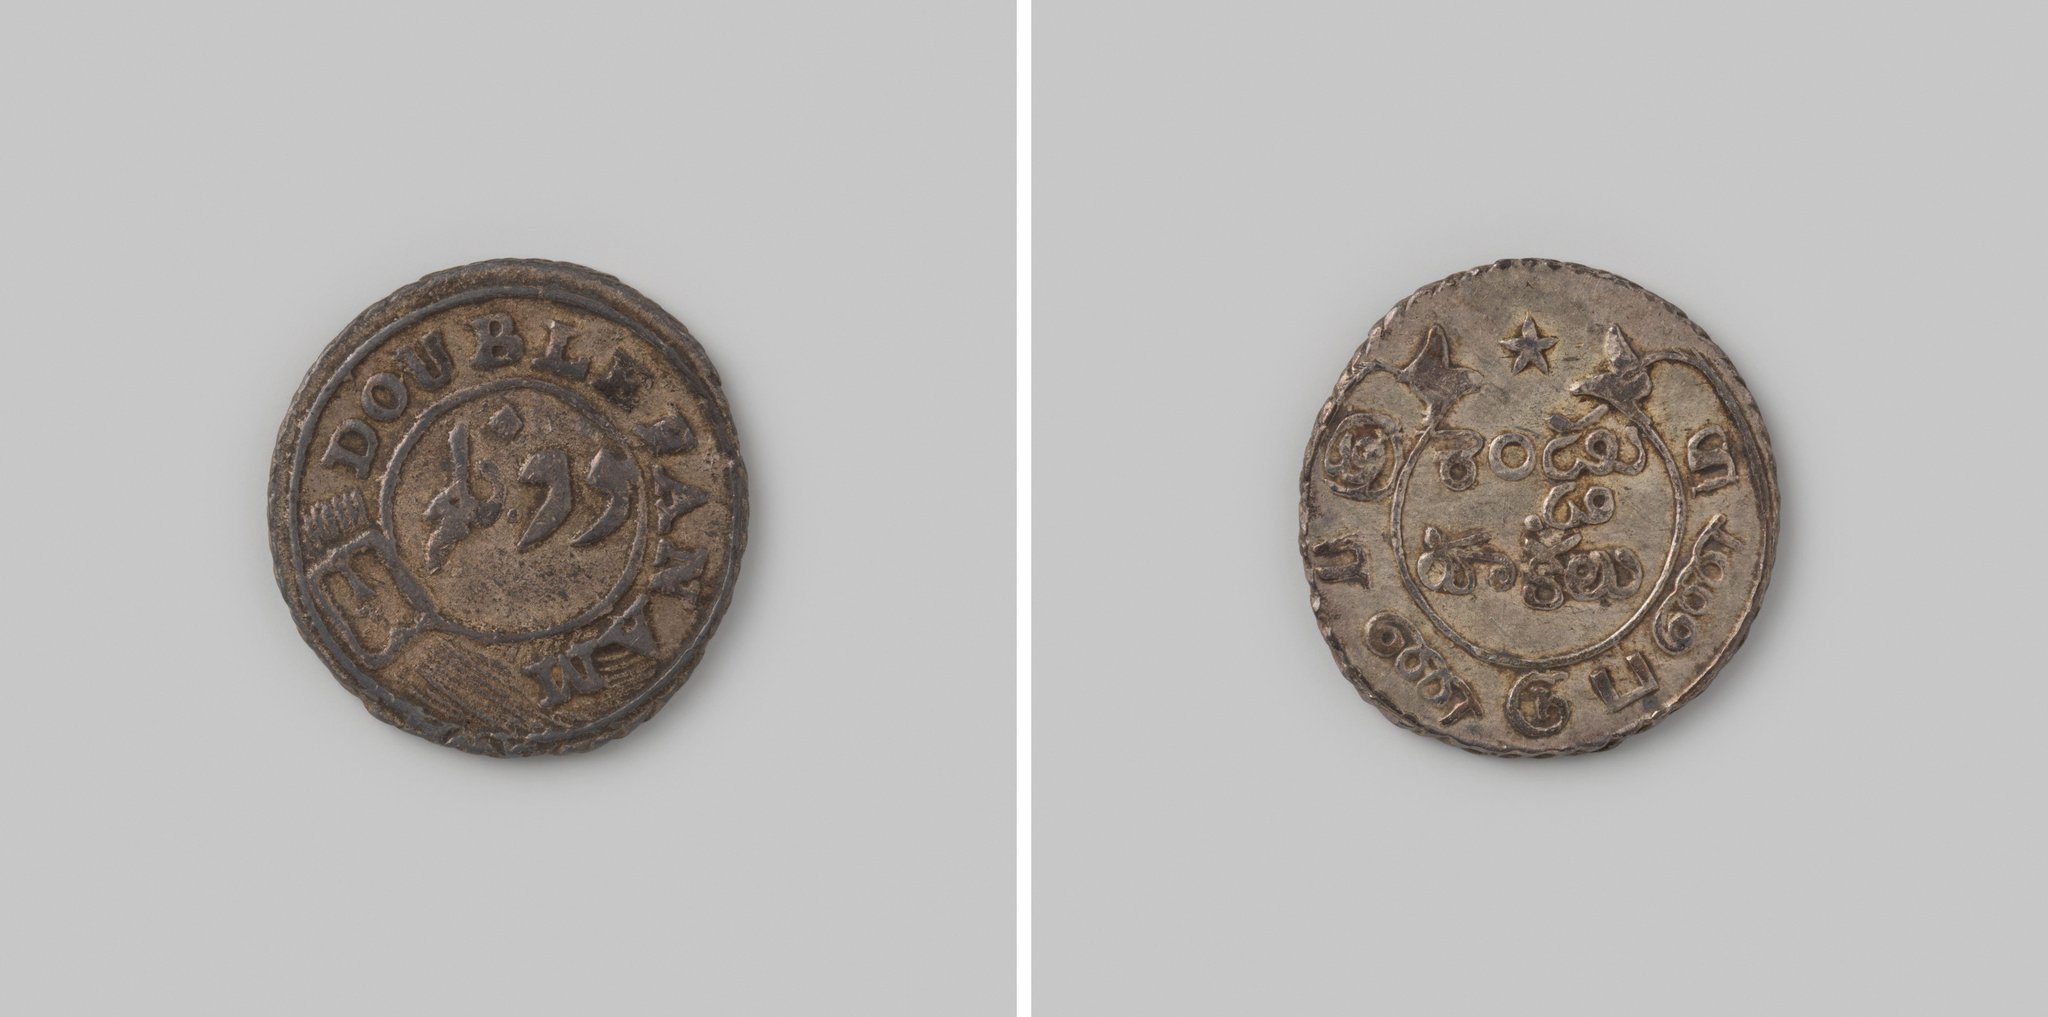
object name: coin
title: Madras, India, Engelse Oostindische Compagnie (EIC), 2 fanams, (1808)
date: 1808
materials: silver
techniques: striking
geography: chennai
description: Zilveren munt. Voorzijde: binnen cirkel, gevormd door ceintuur met gesp, waarde-aanduiding in het Engels: double fanam, op een regel waarde-aanduiding in Arabische lettertekens. Keerzijde: binnen cirkel, gevormd door lint, waarop waarde-aanduiding in het Tamil, in twee regels waarde-aanduiding in het Telugu. Bovenaan, tussen uiteinden van het lint, een ster. Kabelrand.